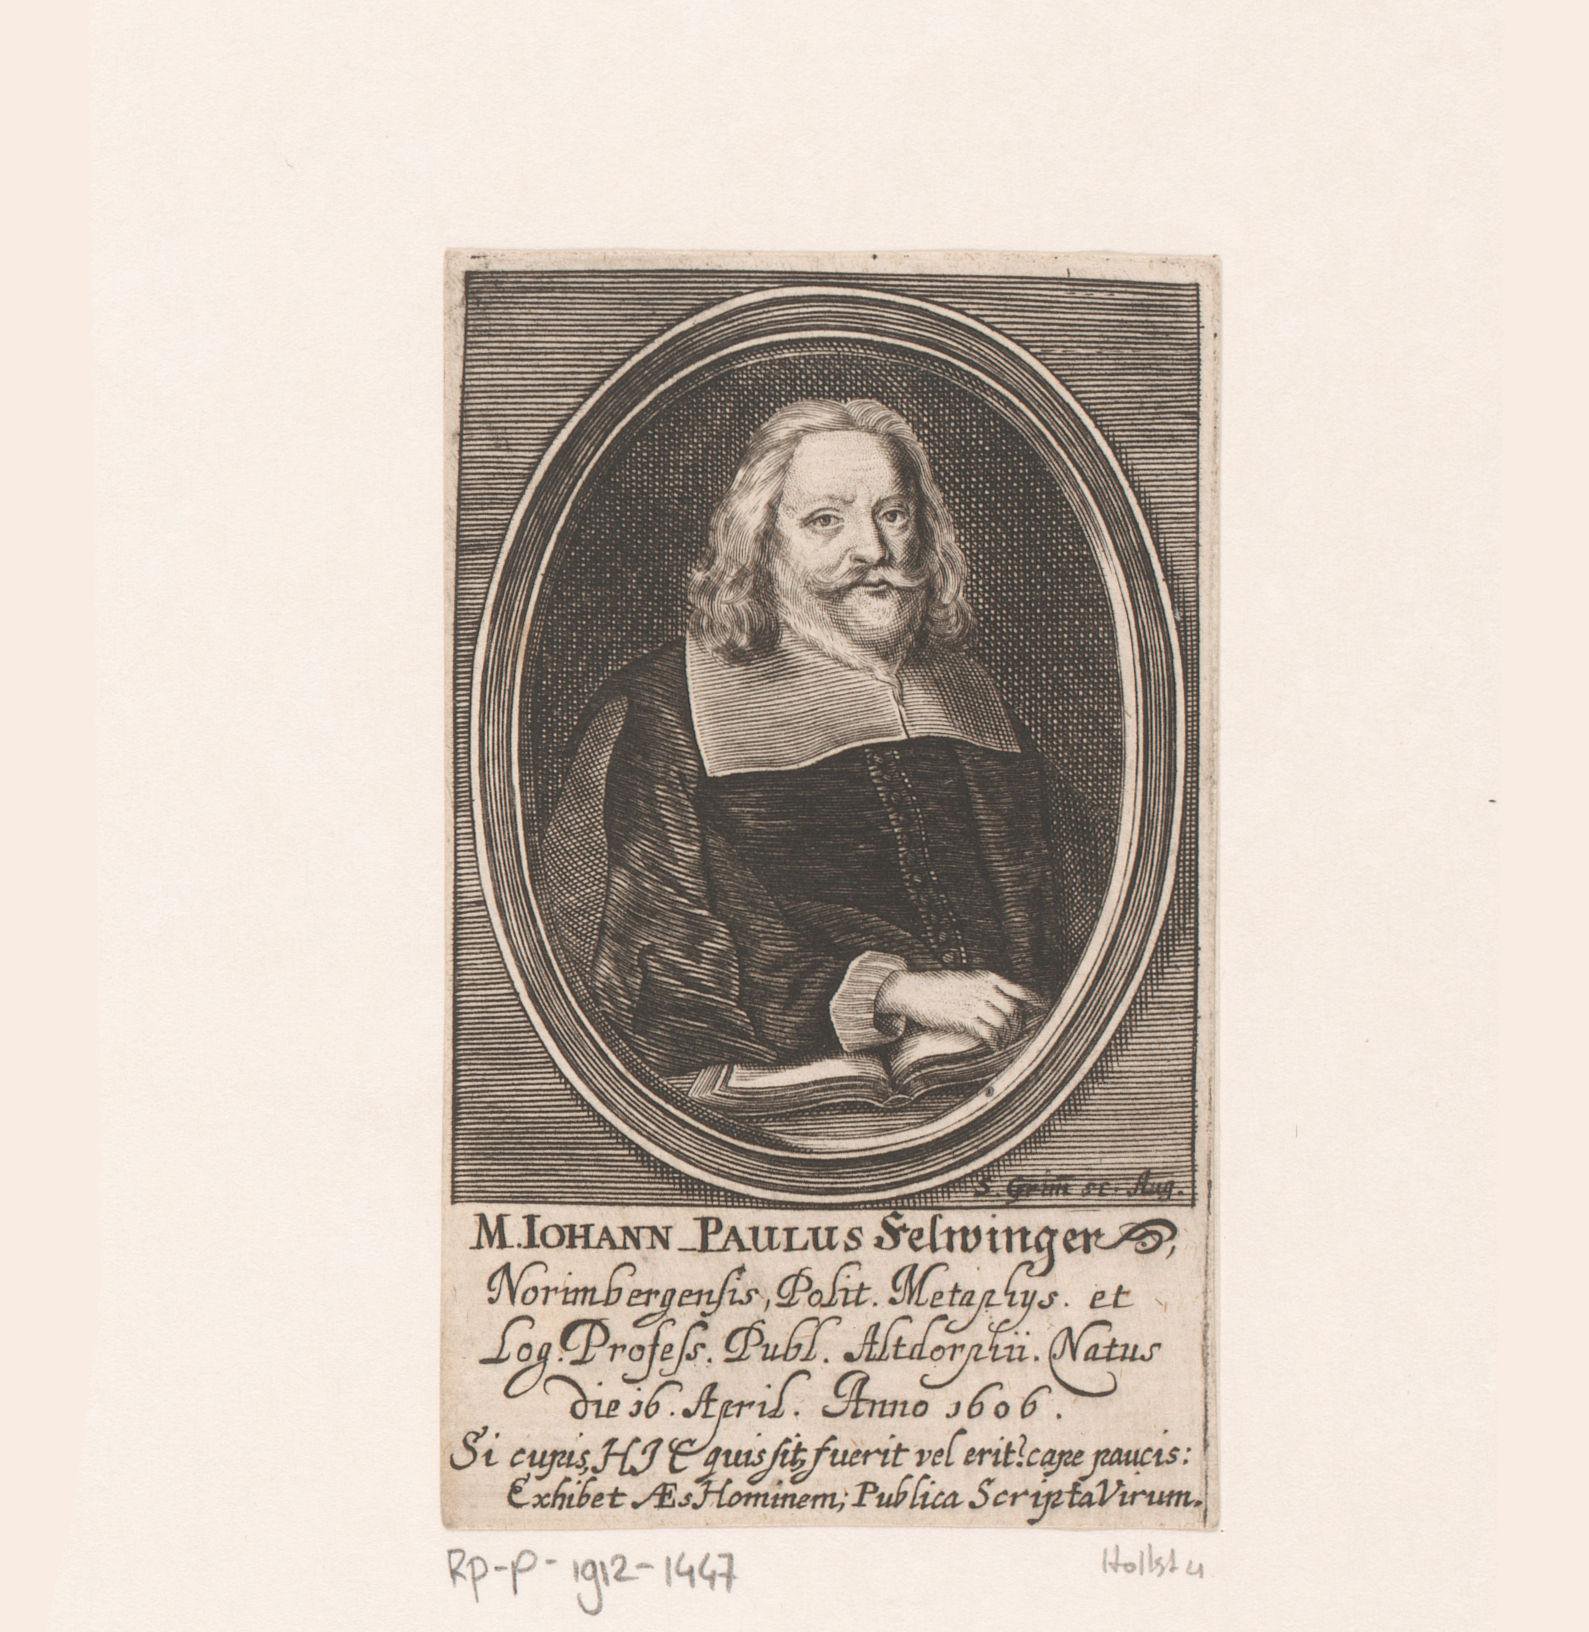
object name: print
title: Portret van Johann Paul Felwinger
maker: simon grimm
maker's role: print maker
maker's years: 1650-1682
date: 1654-1669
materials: paper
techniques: engraving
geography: augsburg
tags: historical persons, book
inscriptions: collector's mark: Lugt 2228